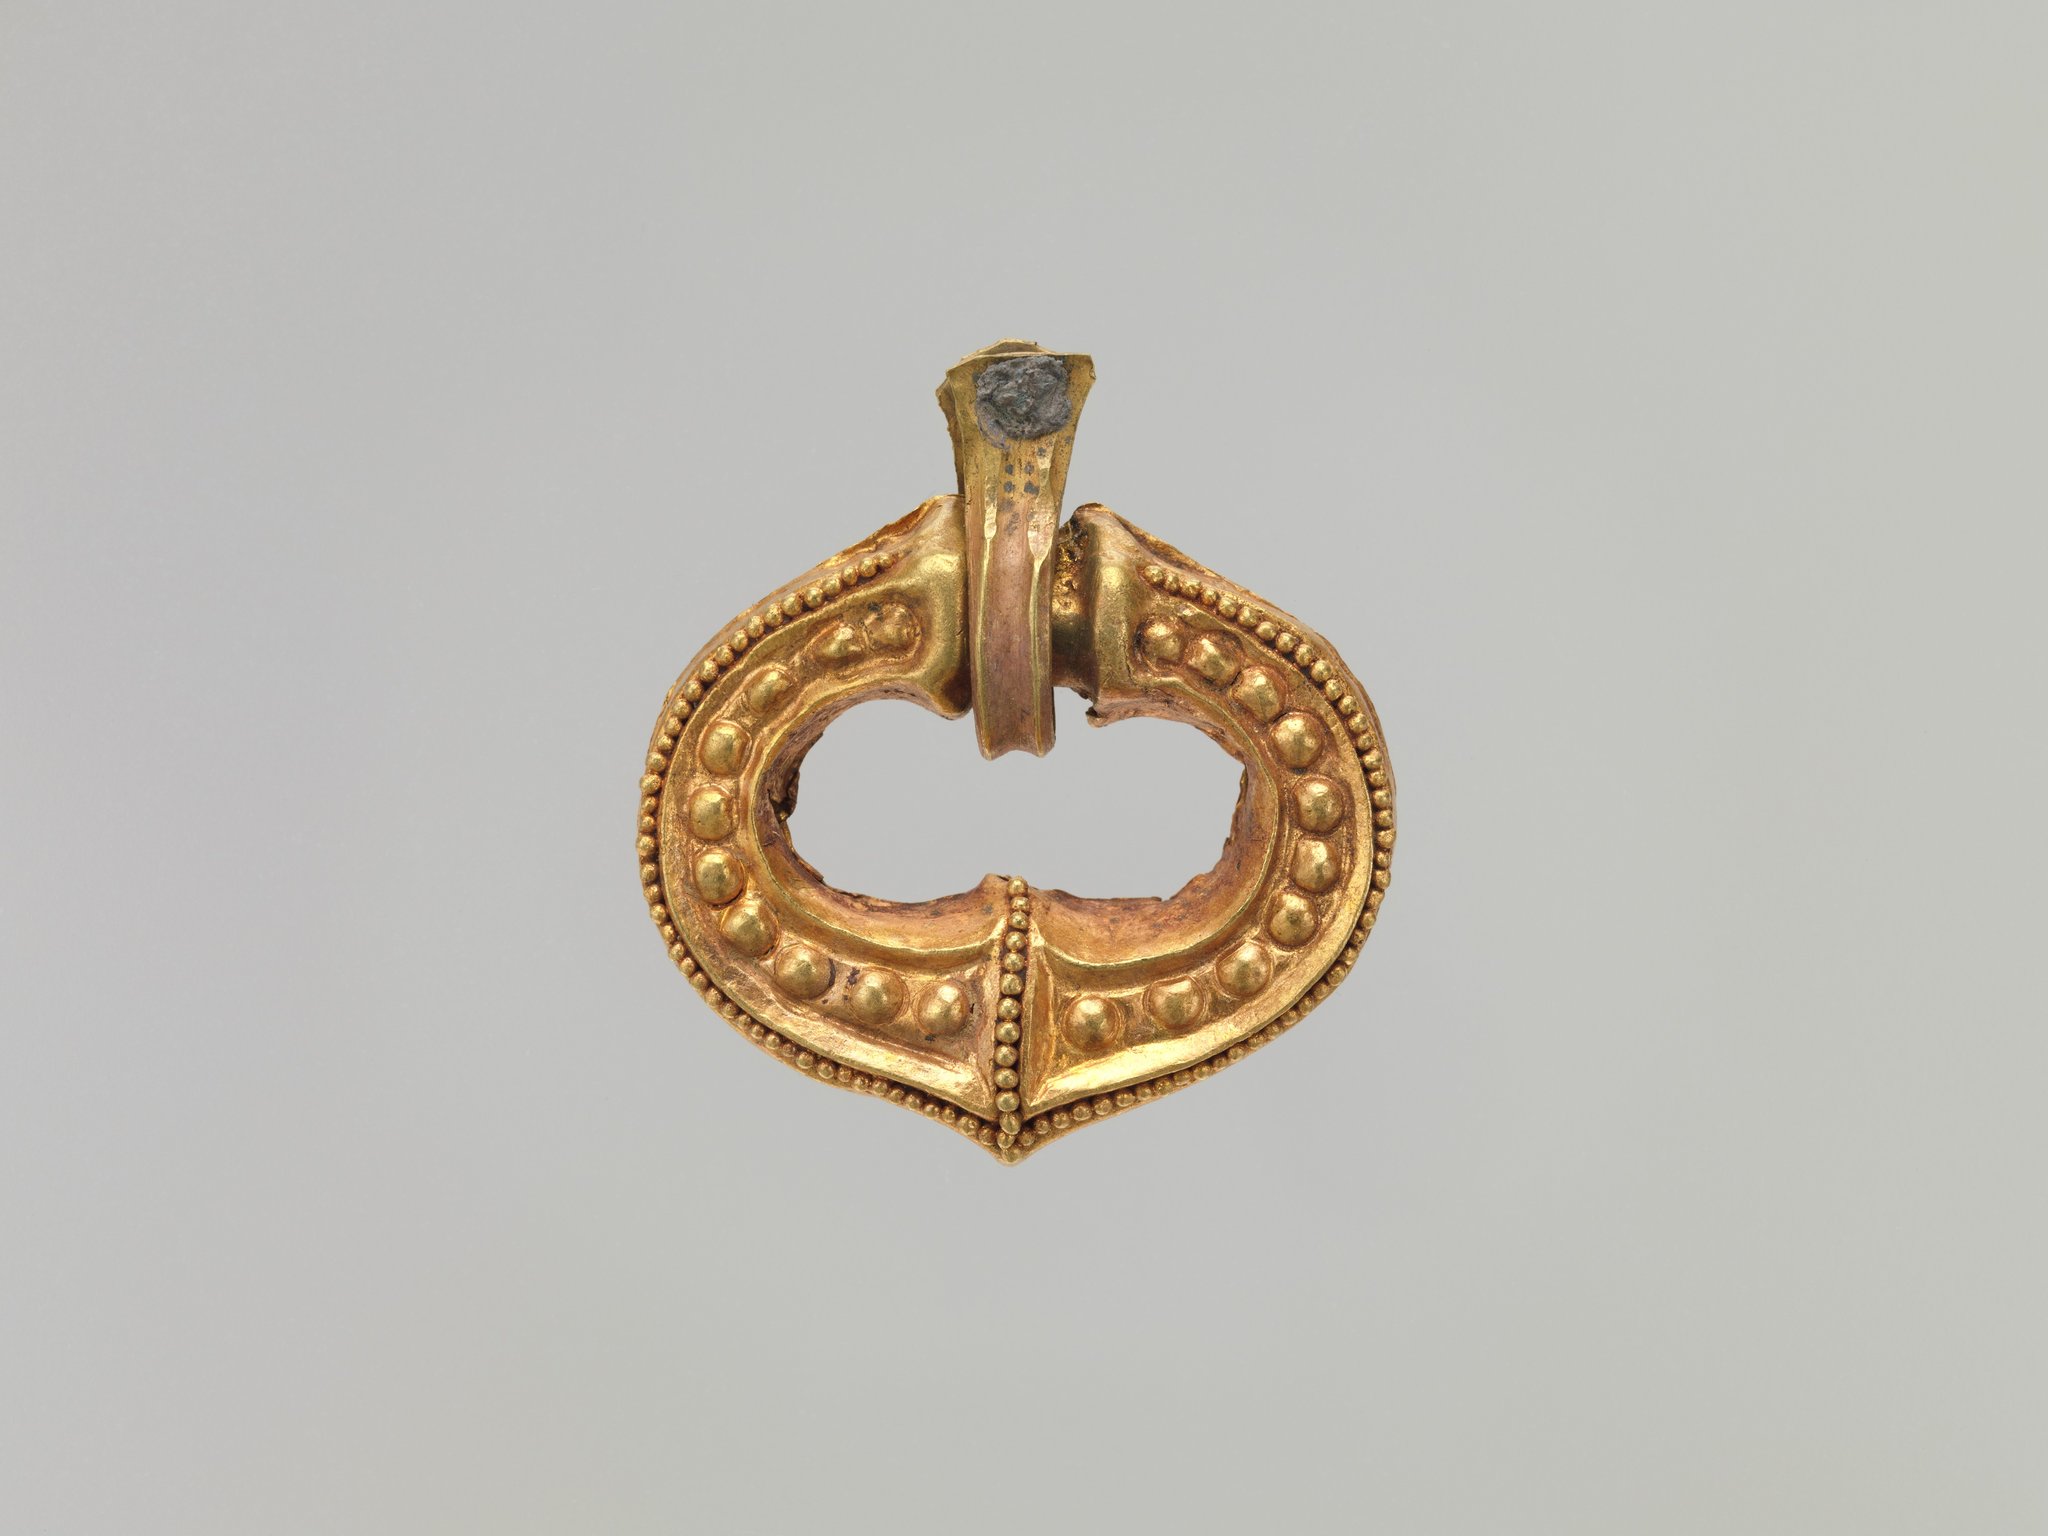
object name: suspension ring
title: Decorated Fitting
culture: chinese or central asian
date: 601-900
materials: gold